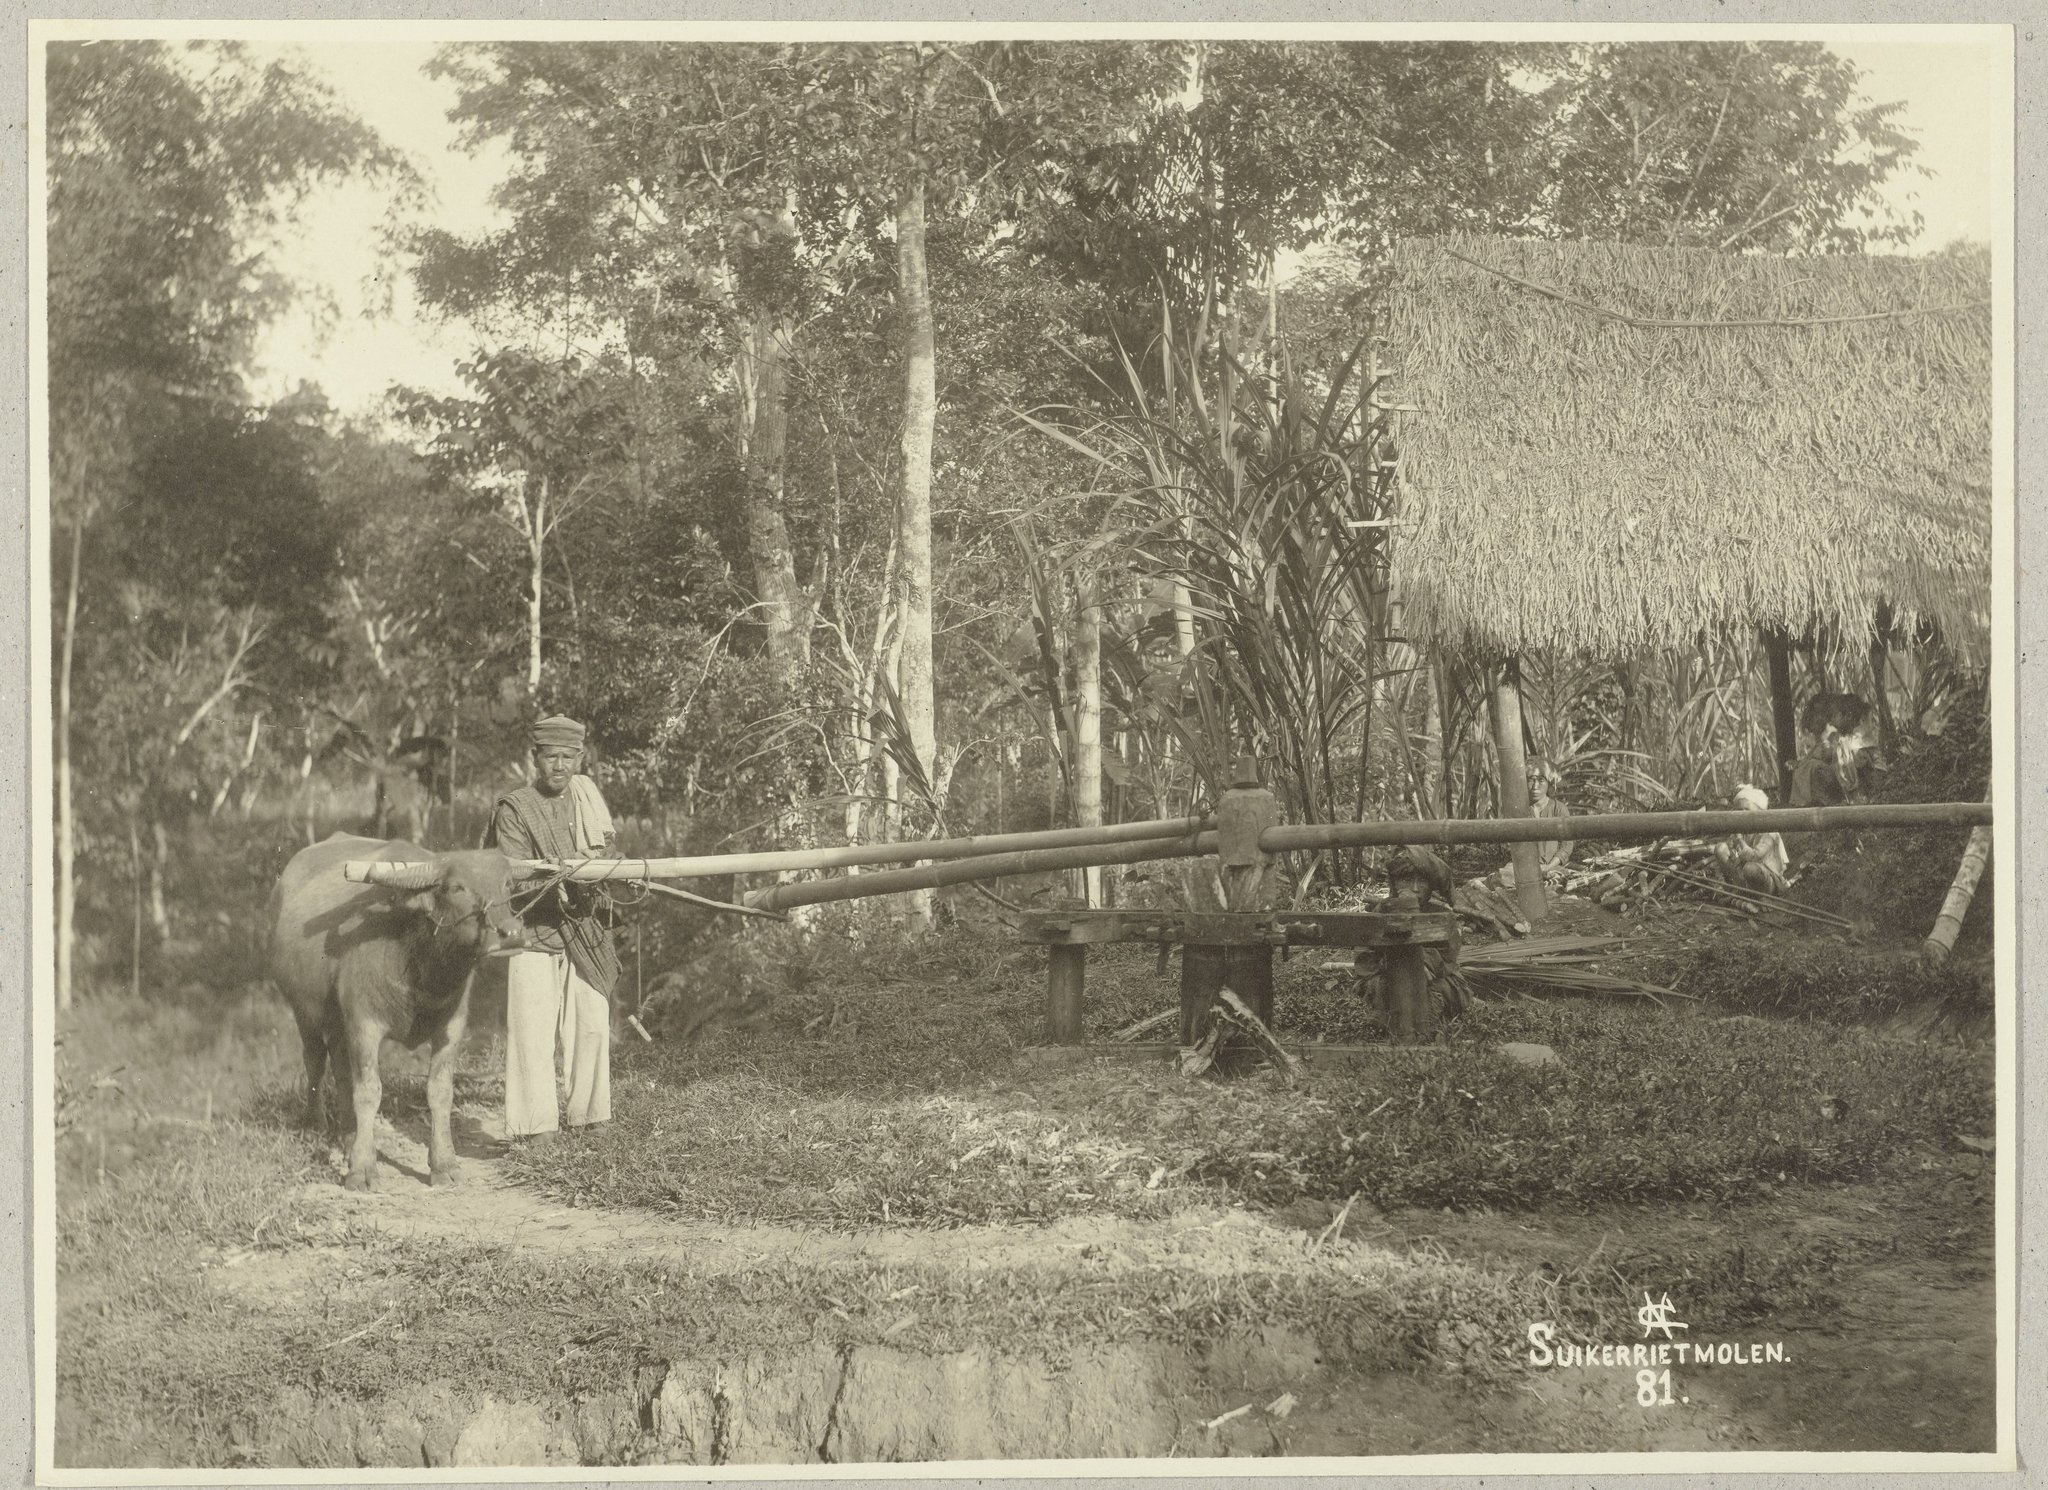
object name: photograph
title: Suikerrietmolen aangedreven door een os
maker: christiaan benjamin nieuwenhuis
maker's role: publisher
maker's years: 1863-1922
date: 1891-1912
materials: paper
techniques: daylight paper print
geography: sumatera barat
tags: ox, grinding, milling (industrial processes), plants and herbs: sugarcane, sumatera barat (province)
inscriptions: signature: ‘CN/ 81.’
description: Een suikerrietmolen in de buitenlucht aangedreven door een os. Naast de os loopt een man die de os aanspoort.